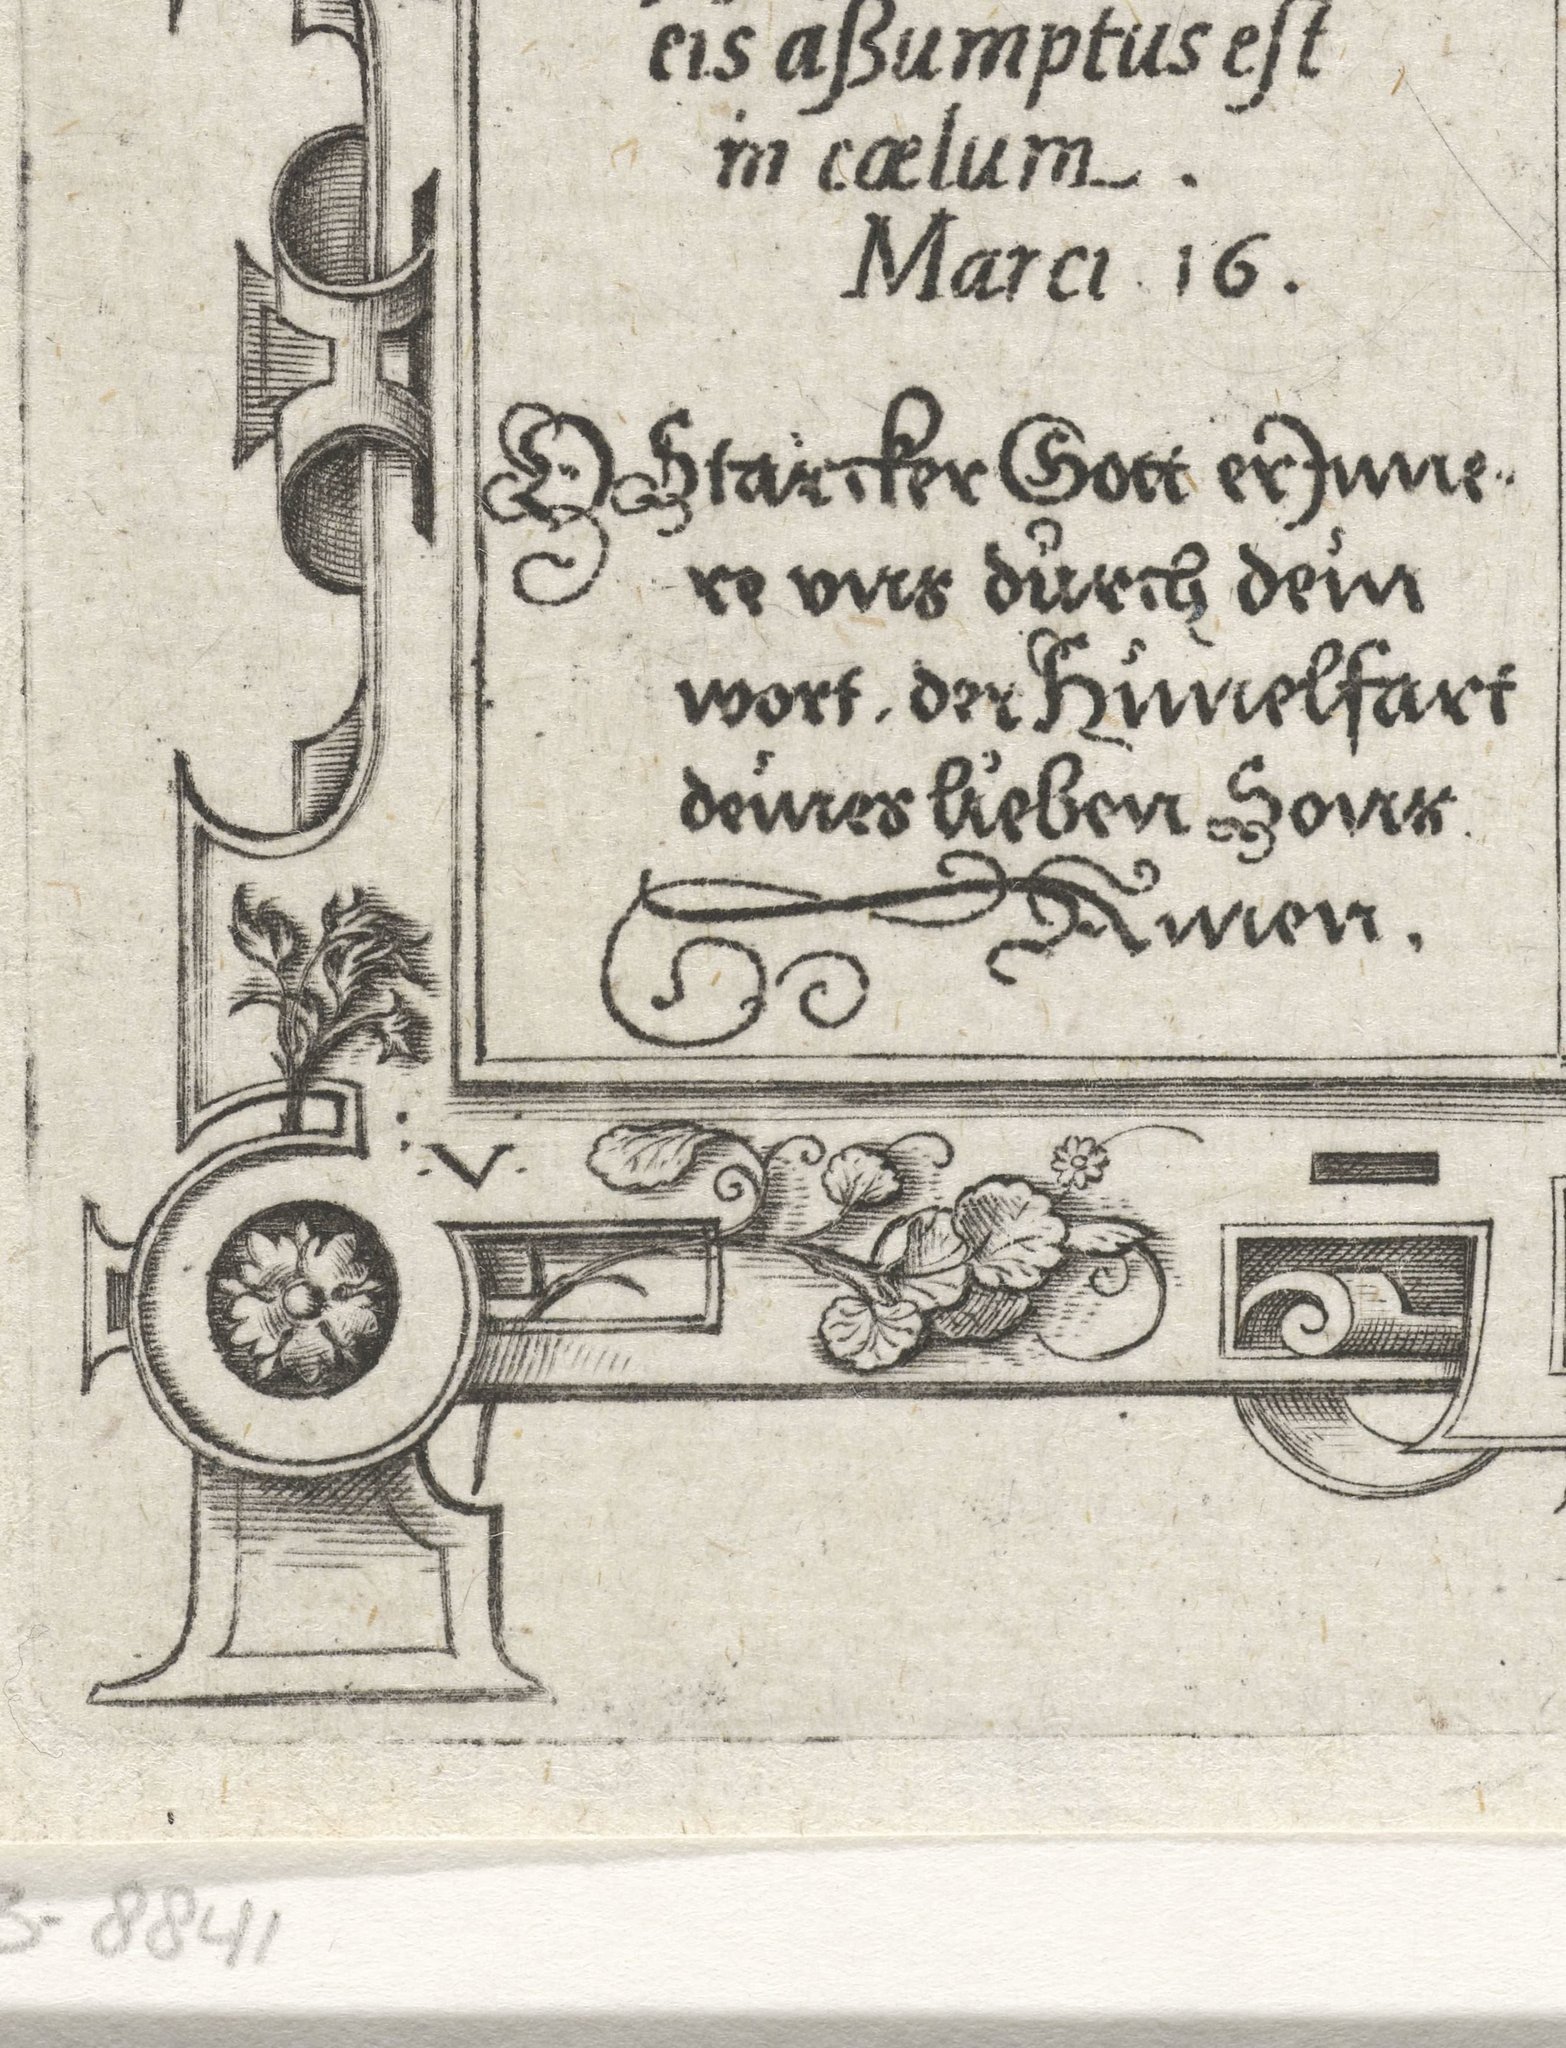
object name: print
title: Tekst: Et Domnus...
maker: virgilius solis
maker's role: draughtsman, print maker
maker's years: 1514-1562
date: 1524-1562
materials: paper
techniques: engraving